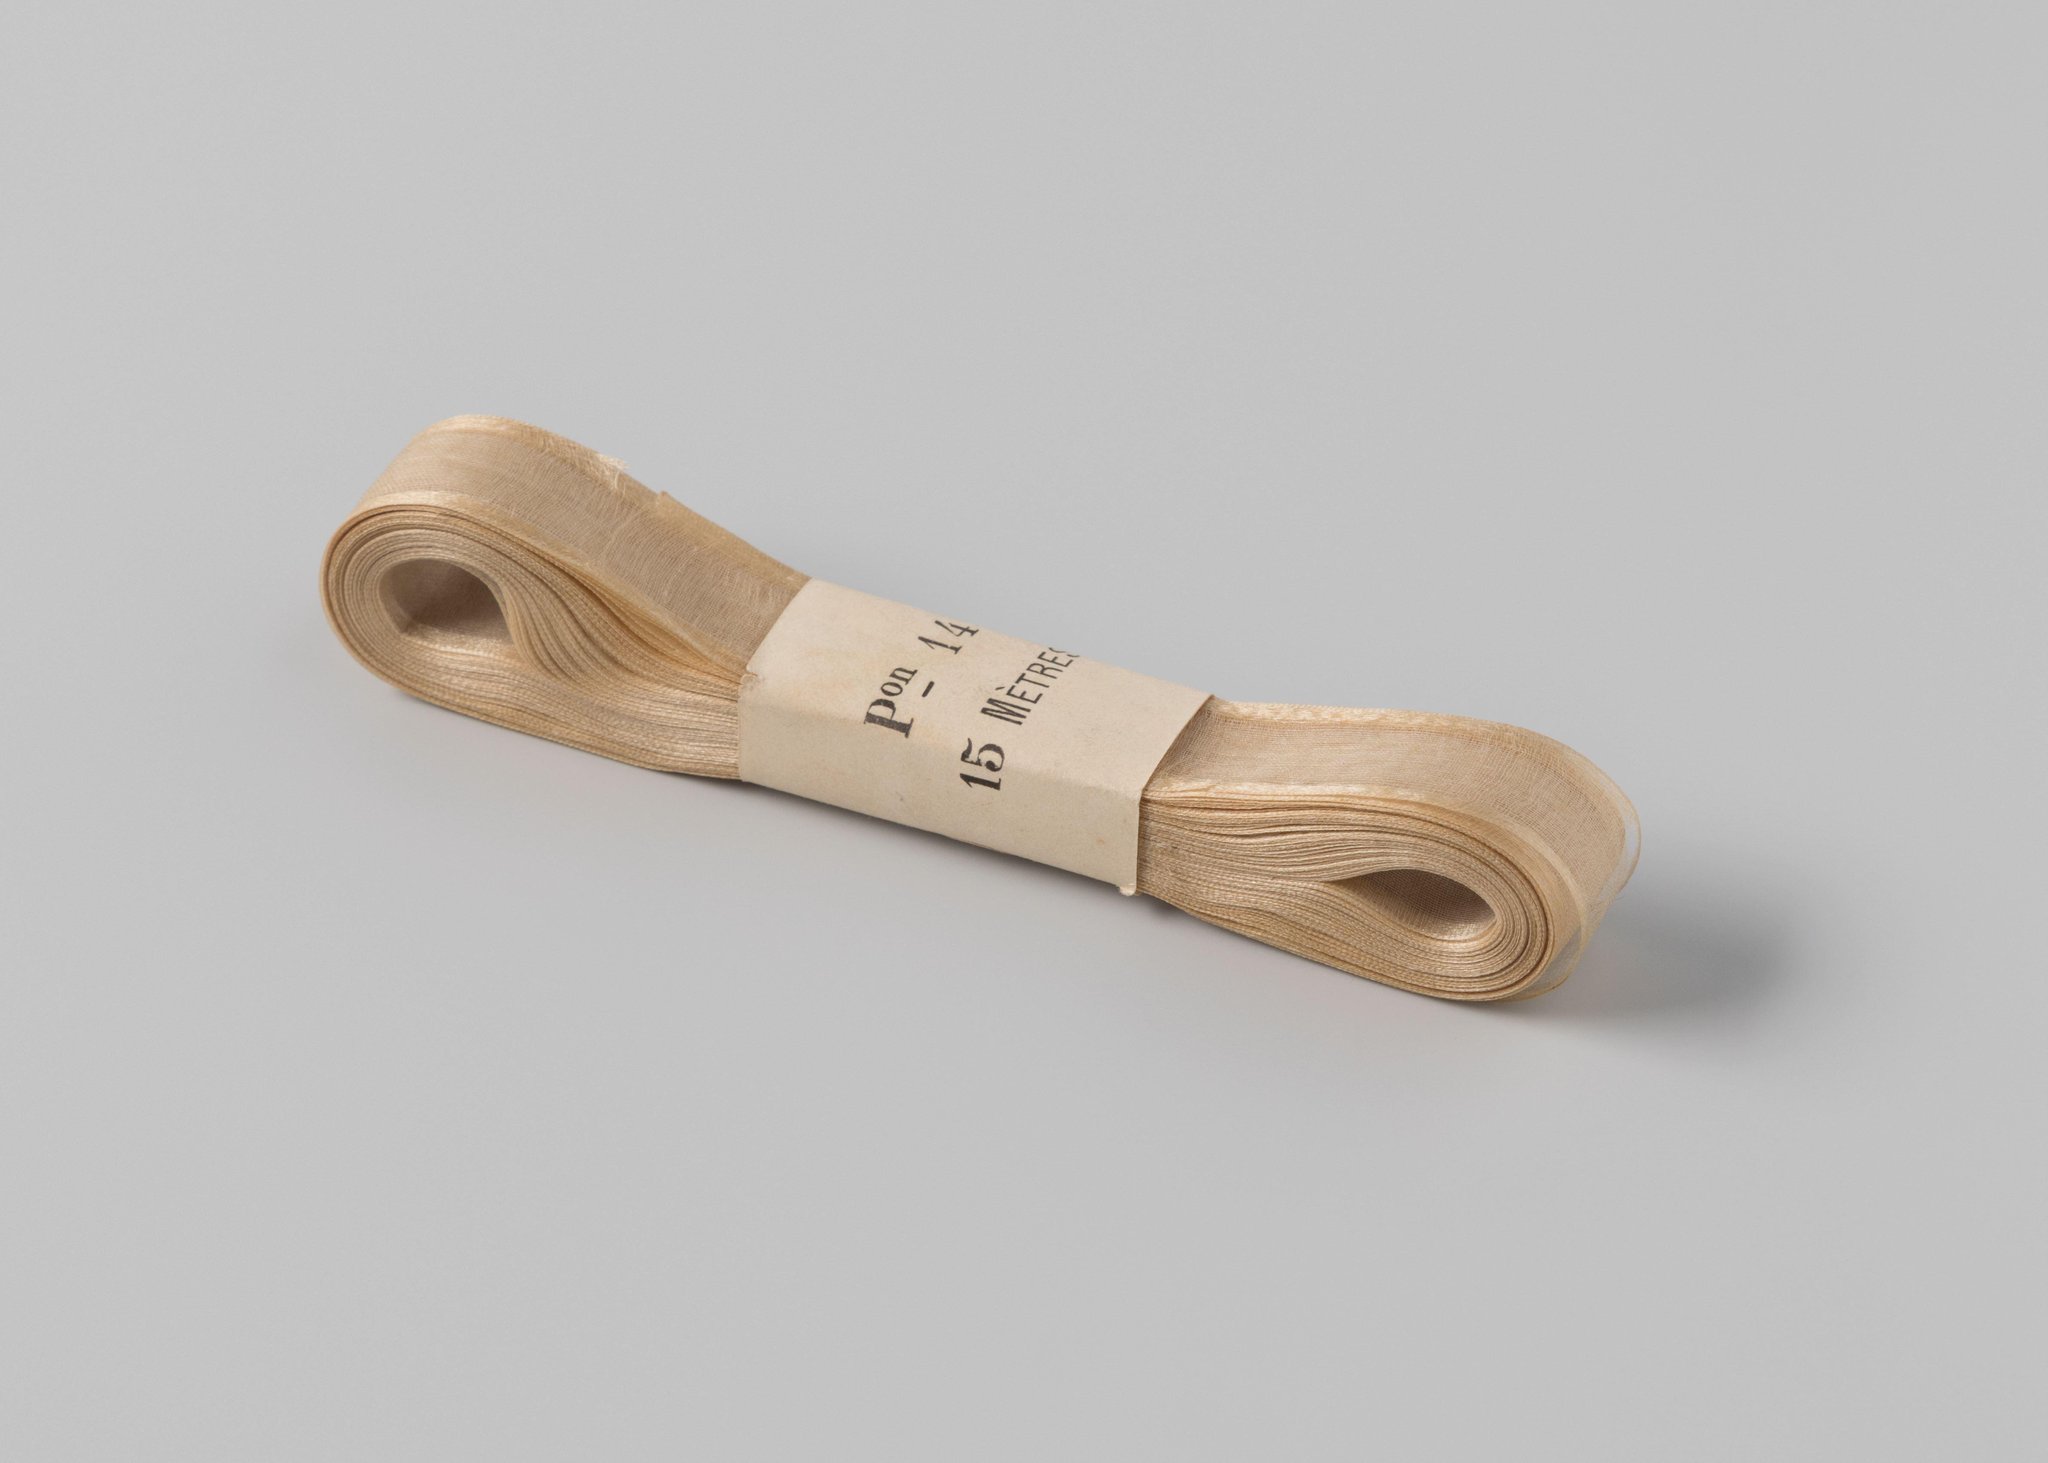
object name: braid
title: Lint van crèmekleurig gaas van 15 meter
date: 1900-1915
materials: textile, silk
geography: france